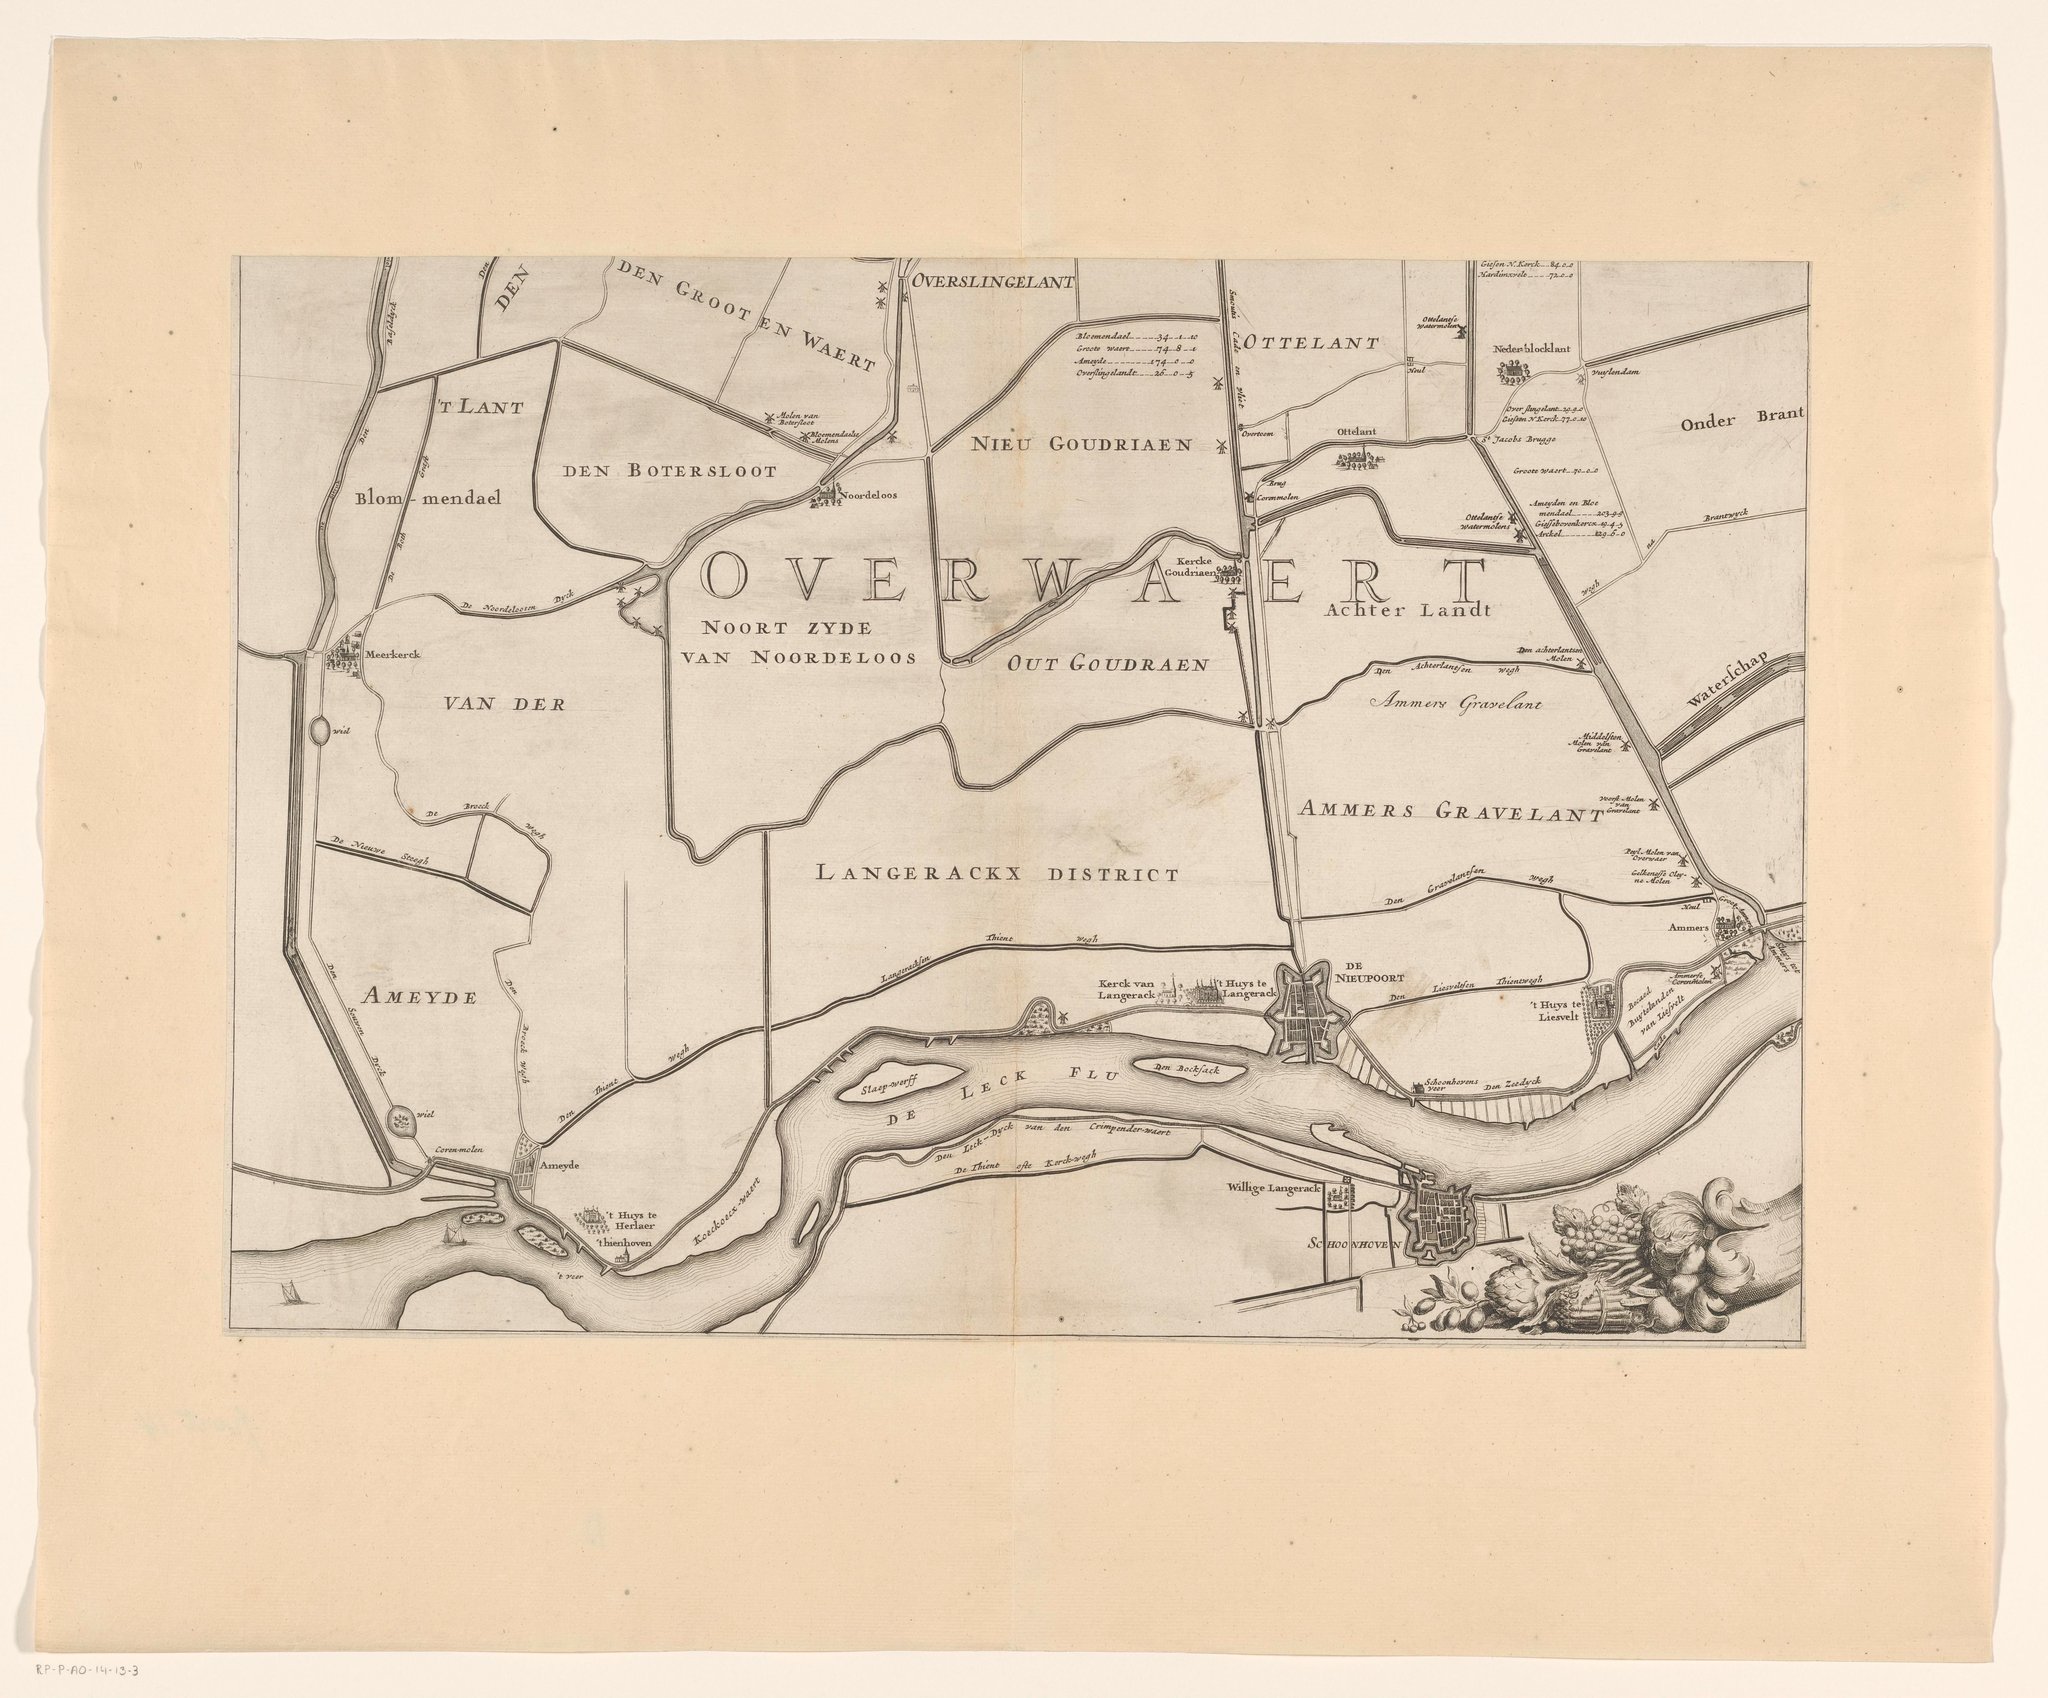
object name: print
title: Caarte van den Overwaart / Het Heemraatschap van den Overwaart groot 12728 1/6 mergen; gesticht by hertog Albrecht van Beyeren, Ao. 1366 / Caerte vertoonende de landen etc. van den Overwaert gelegen binnen den Ringdyk van den Alblasserwaert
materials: paper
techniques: engraving, etching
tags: maps of separate countries or regions, polder, reclaimed land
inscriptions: collector's mark: Lugt 195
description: Deel (linksonder) van een kaart van de Overwaard. Oriëntatie: noorden linksonder.